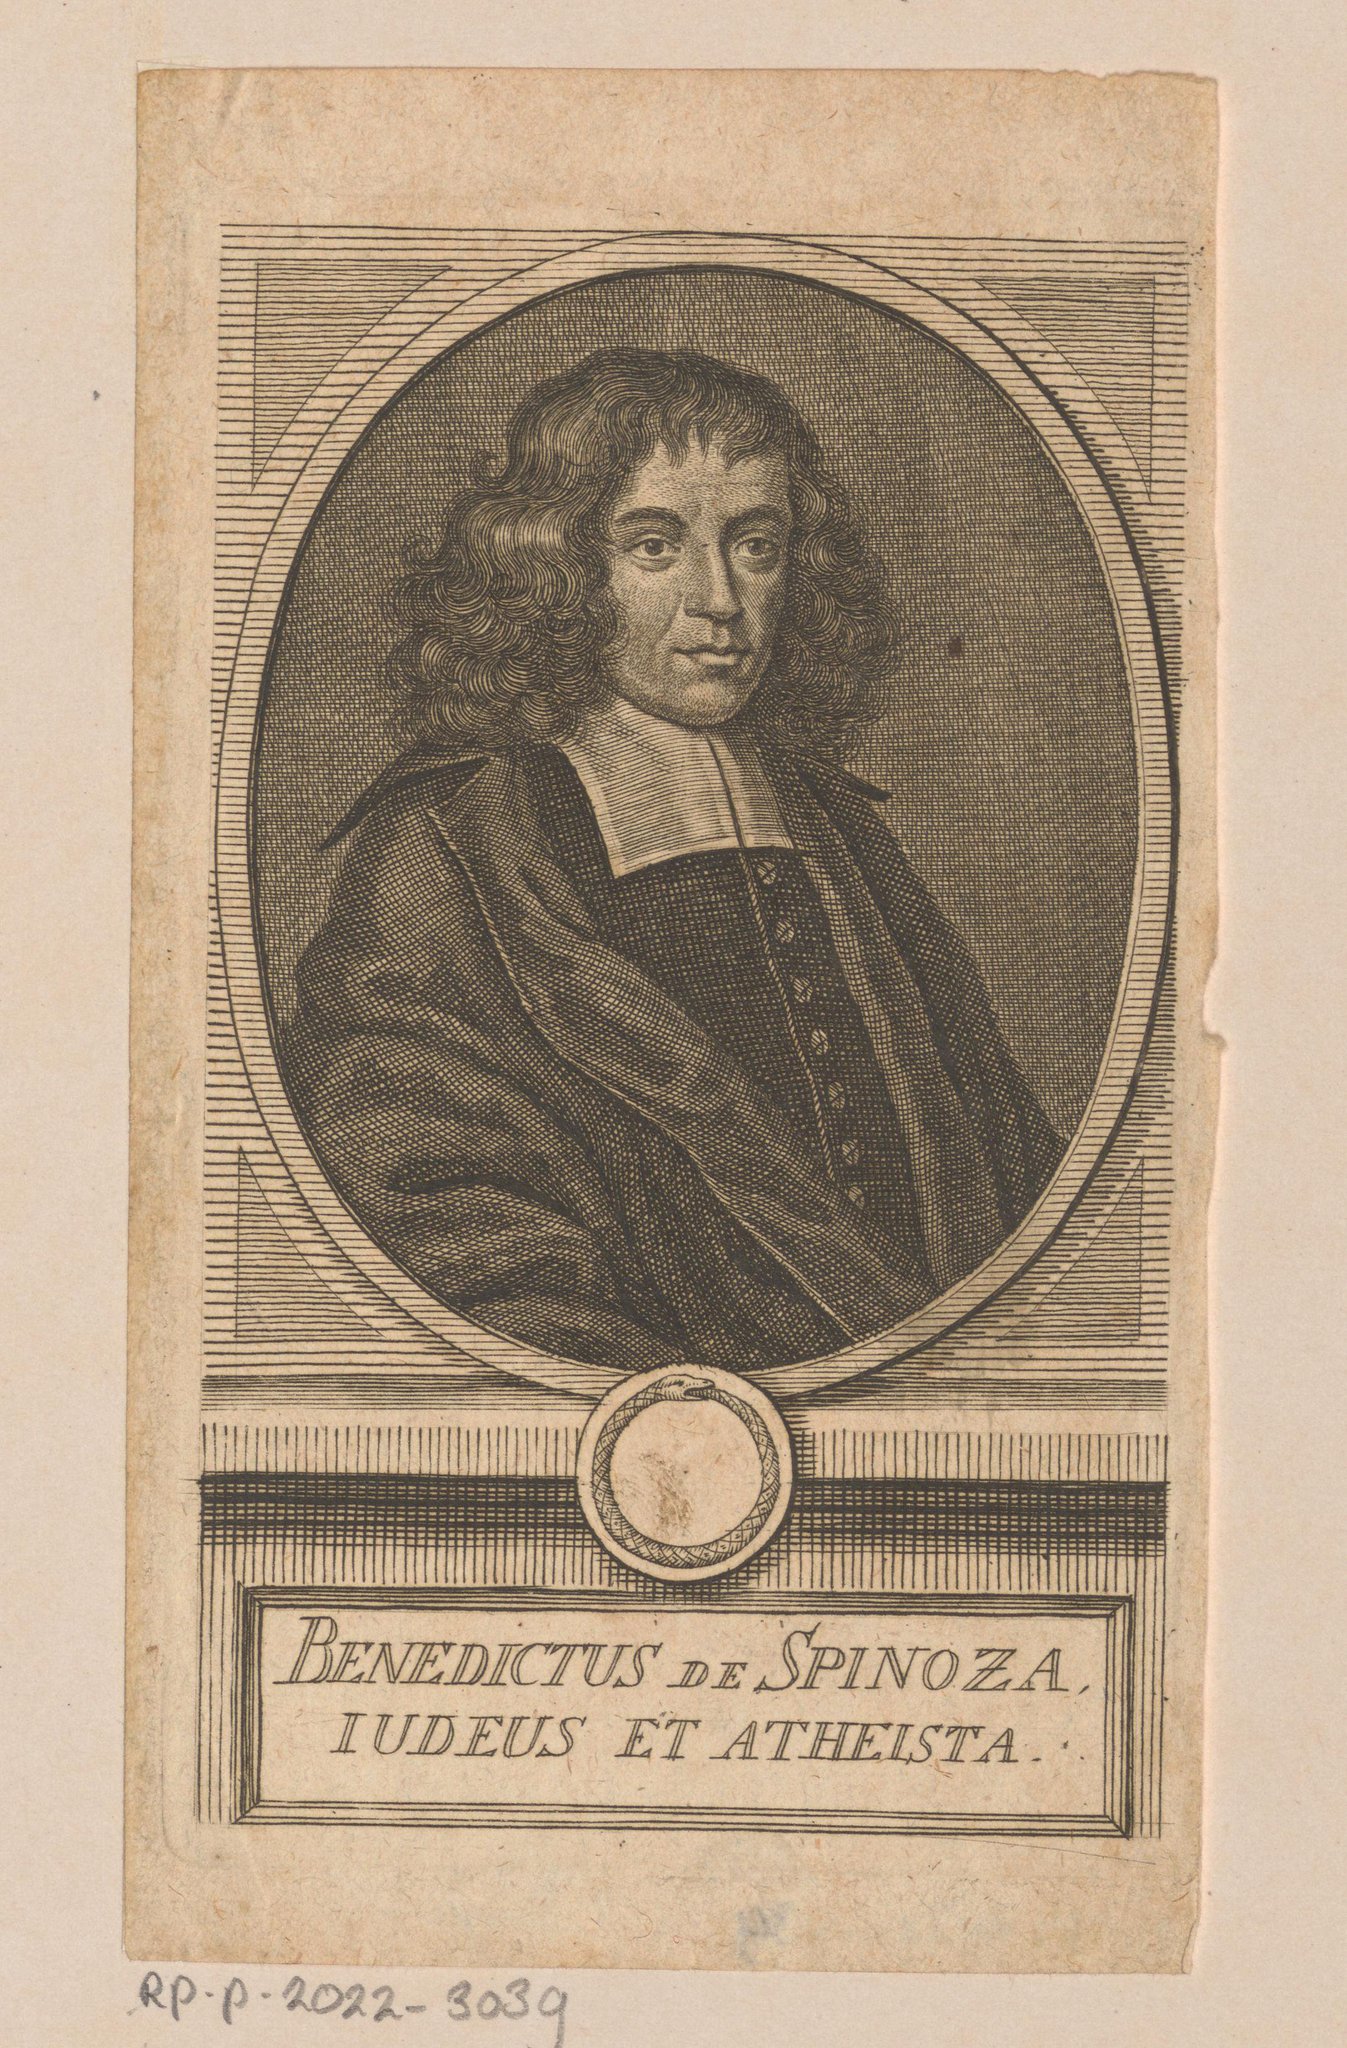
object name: print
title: Portret van Baruch de Spinoza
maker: Anonymous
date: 1660-1750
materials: paper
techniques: engraving, etching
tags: amsterdam, the hague, baruch de spinoza, historical persons, scholar, philosopher (+ portrait of scholar, scientist)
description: Met tweeregelig onderschrift in het Latijn.